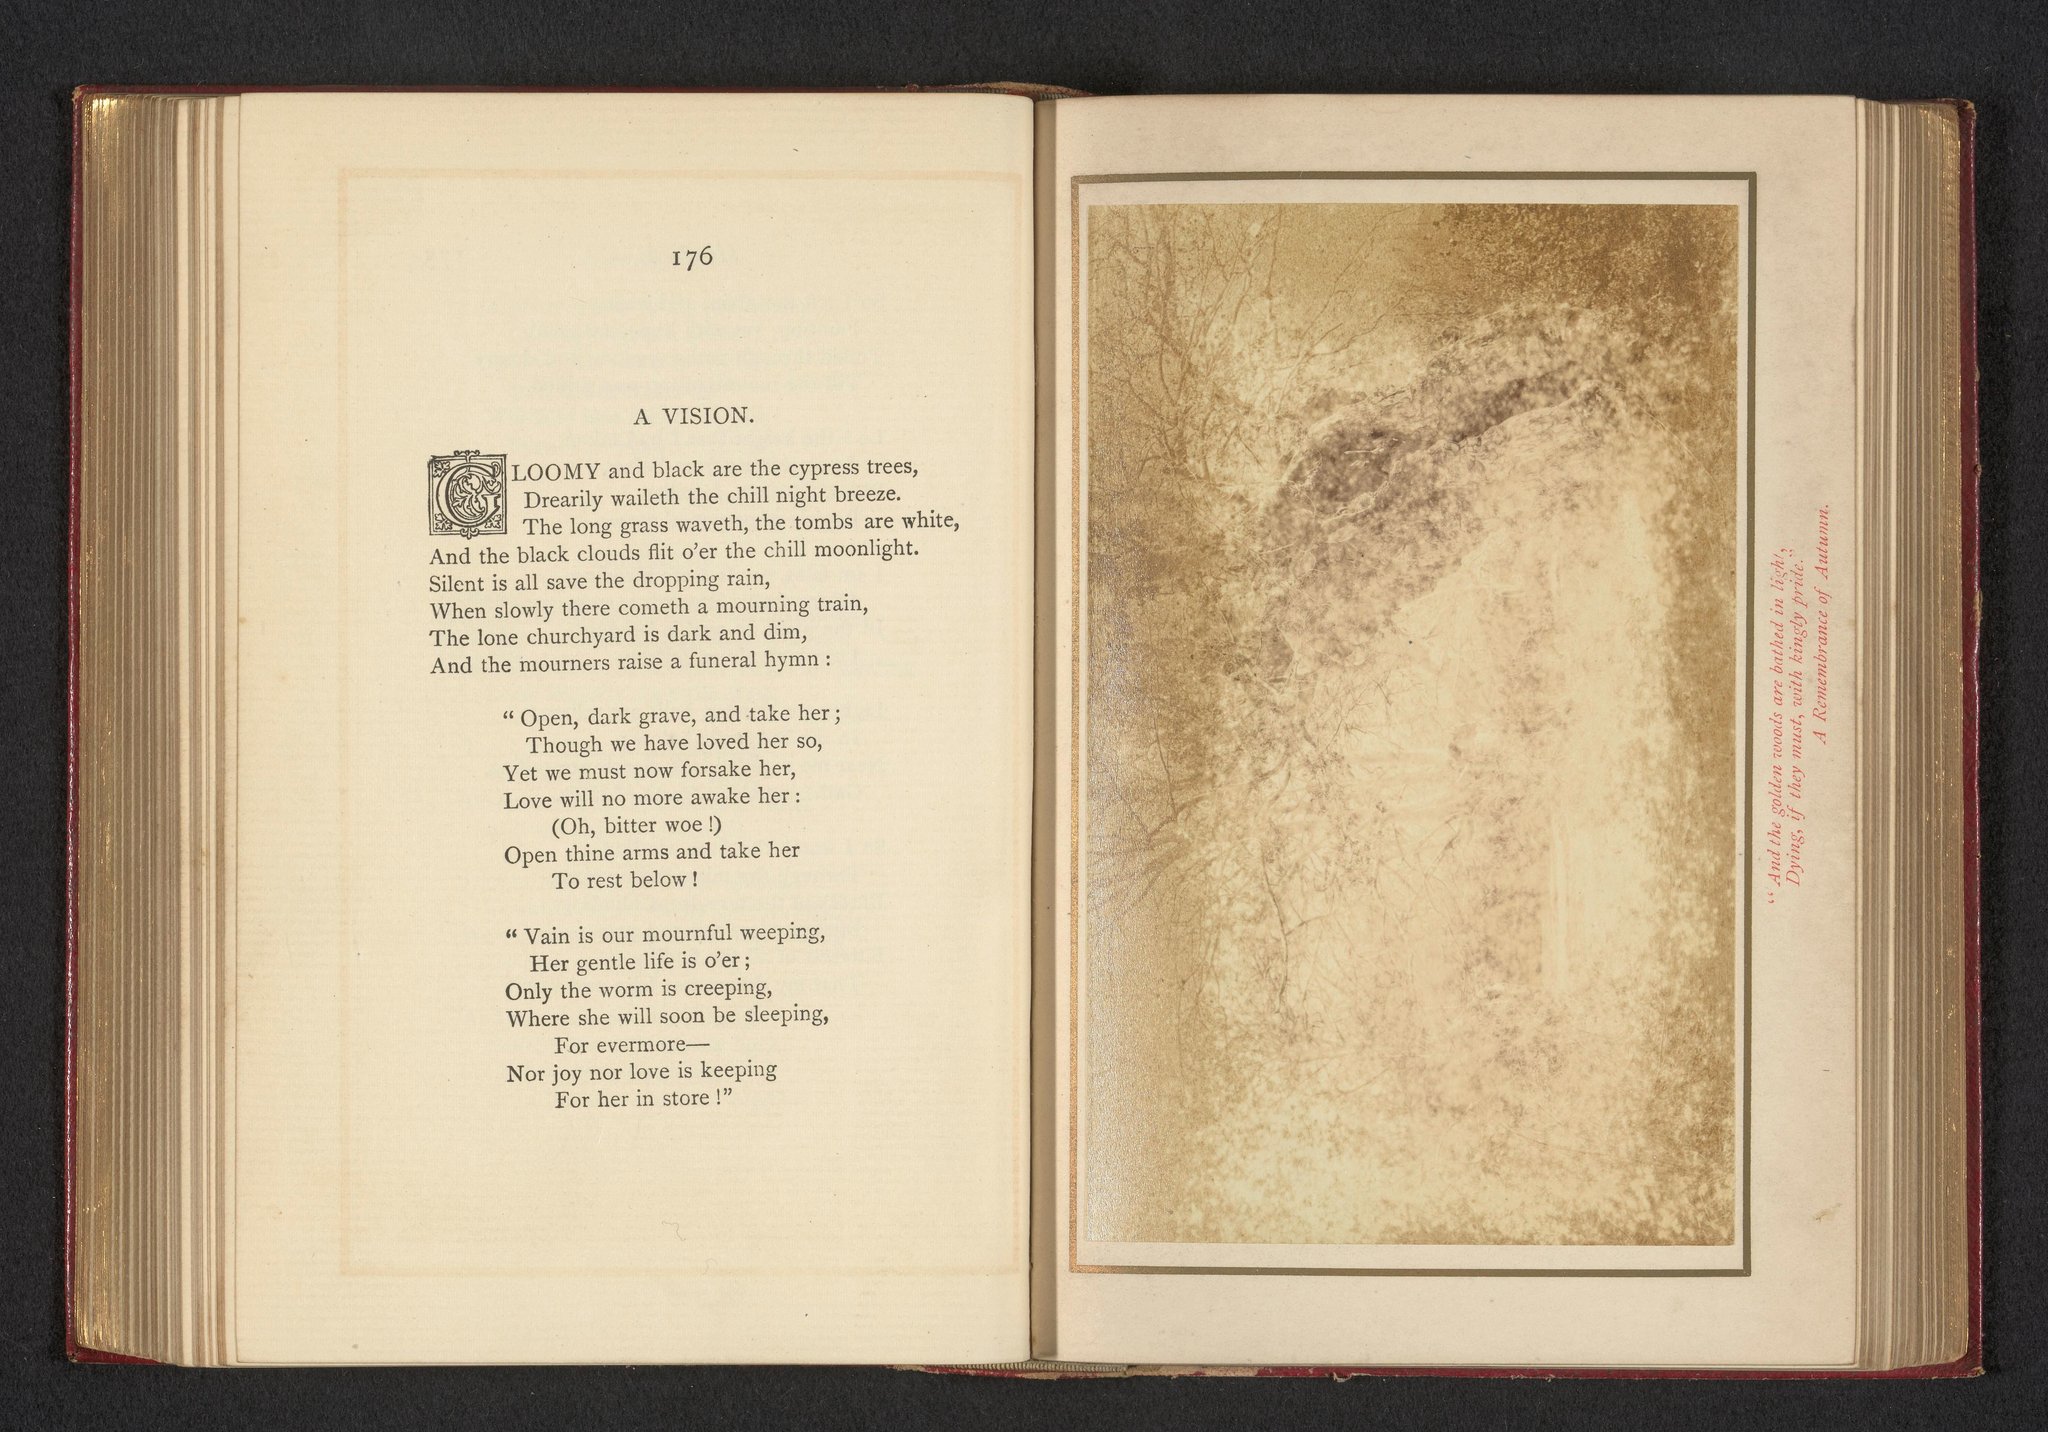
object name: photograph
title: Gezicht op vermoedelijk een meer in een bos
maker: john payne jennings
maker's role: fotograaf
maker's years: 1843-1926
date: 1872-1882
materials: photographic support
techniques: albumen print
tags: forest, wood, pool, puddle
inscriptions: inscription: ‘“ And the golden woods are bathed in light, Dying, if they must, with kingly pride.” A Rememberance of Autumn.’